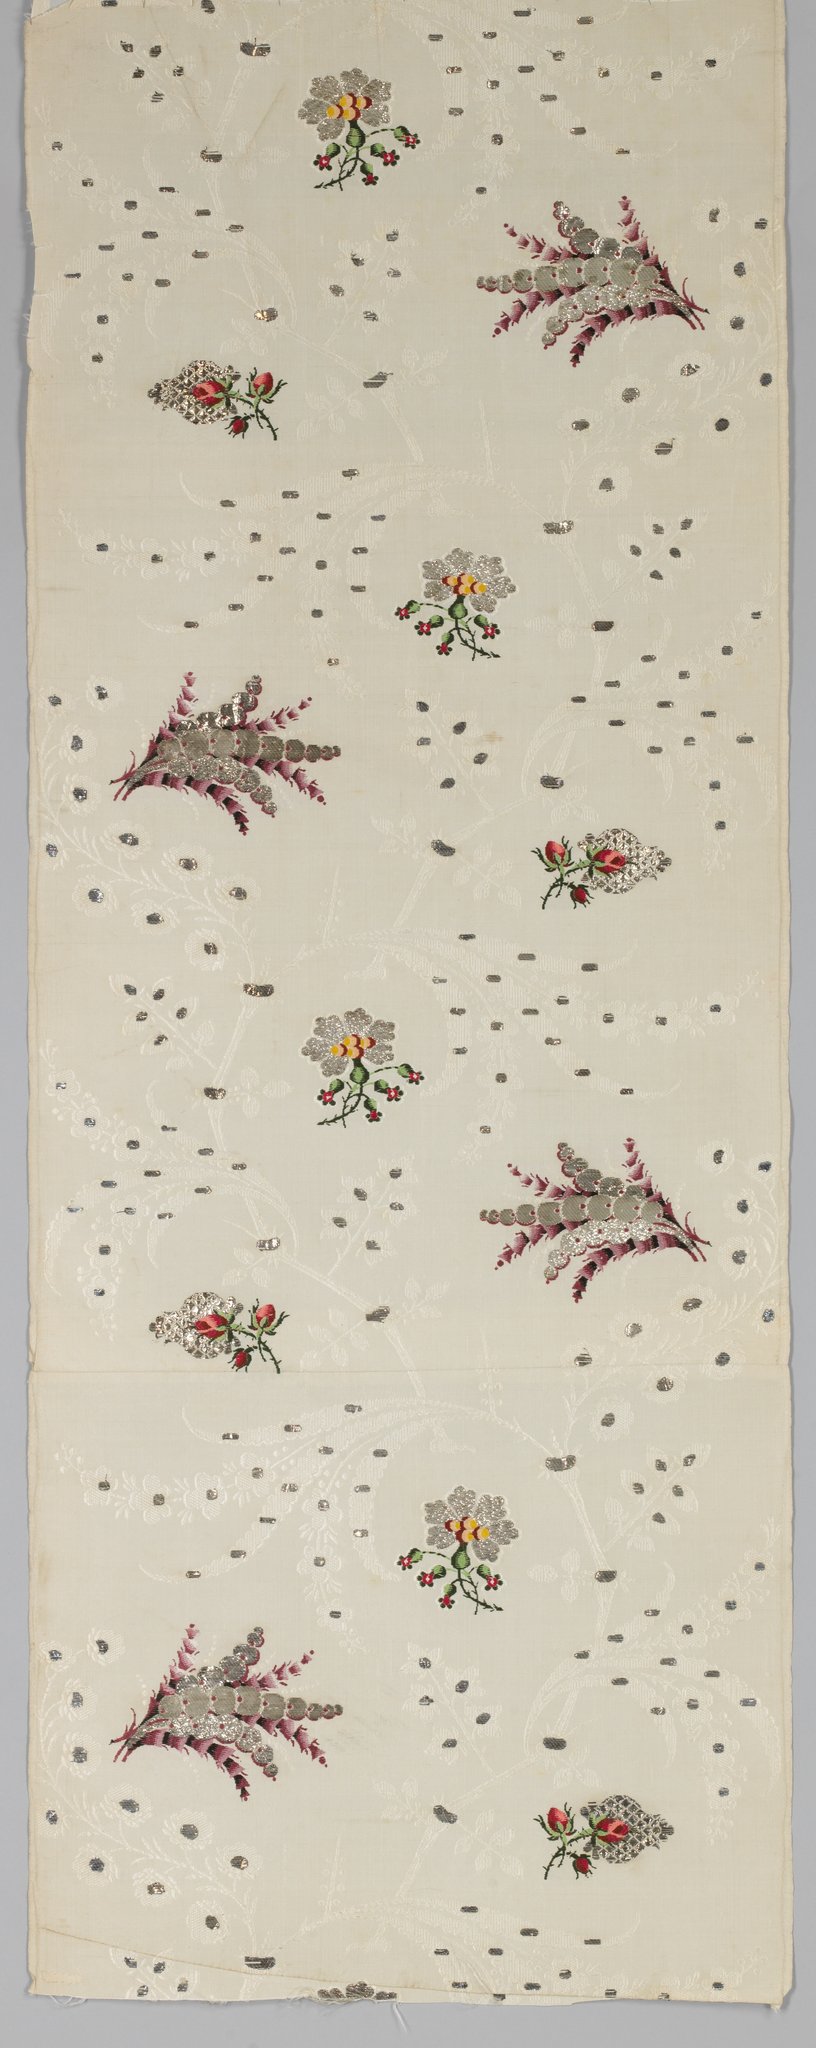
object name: piece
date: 1750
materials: metal thread, silk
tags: flowers,leaves